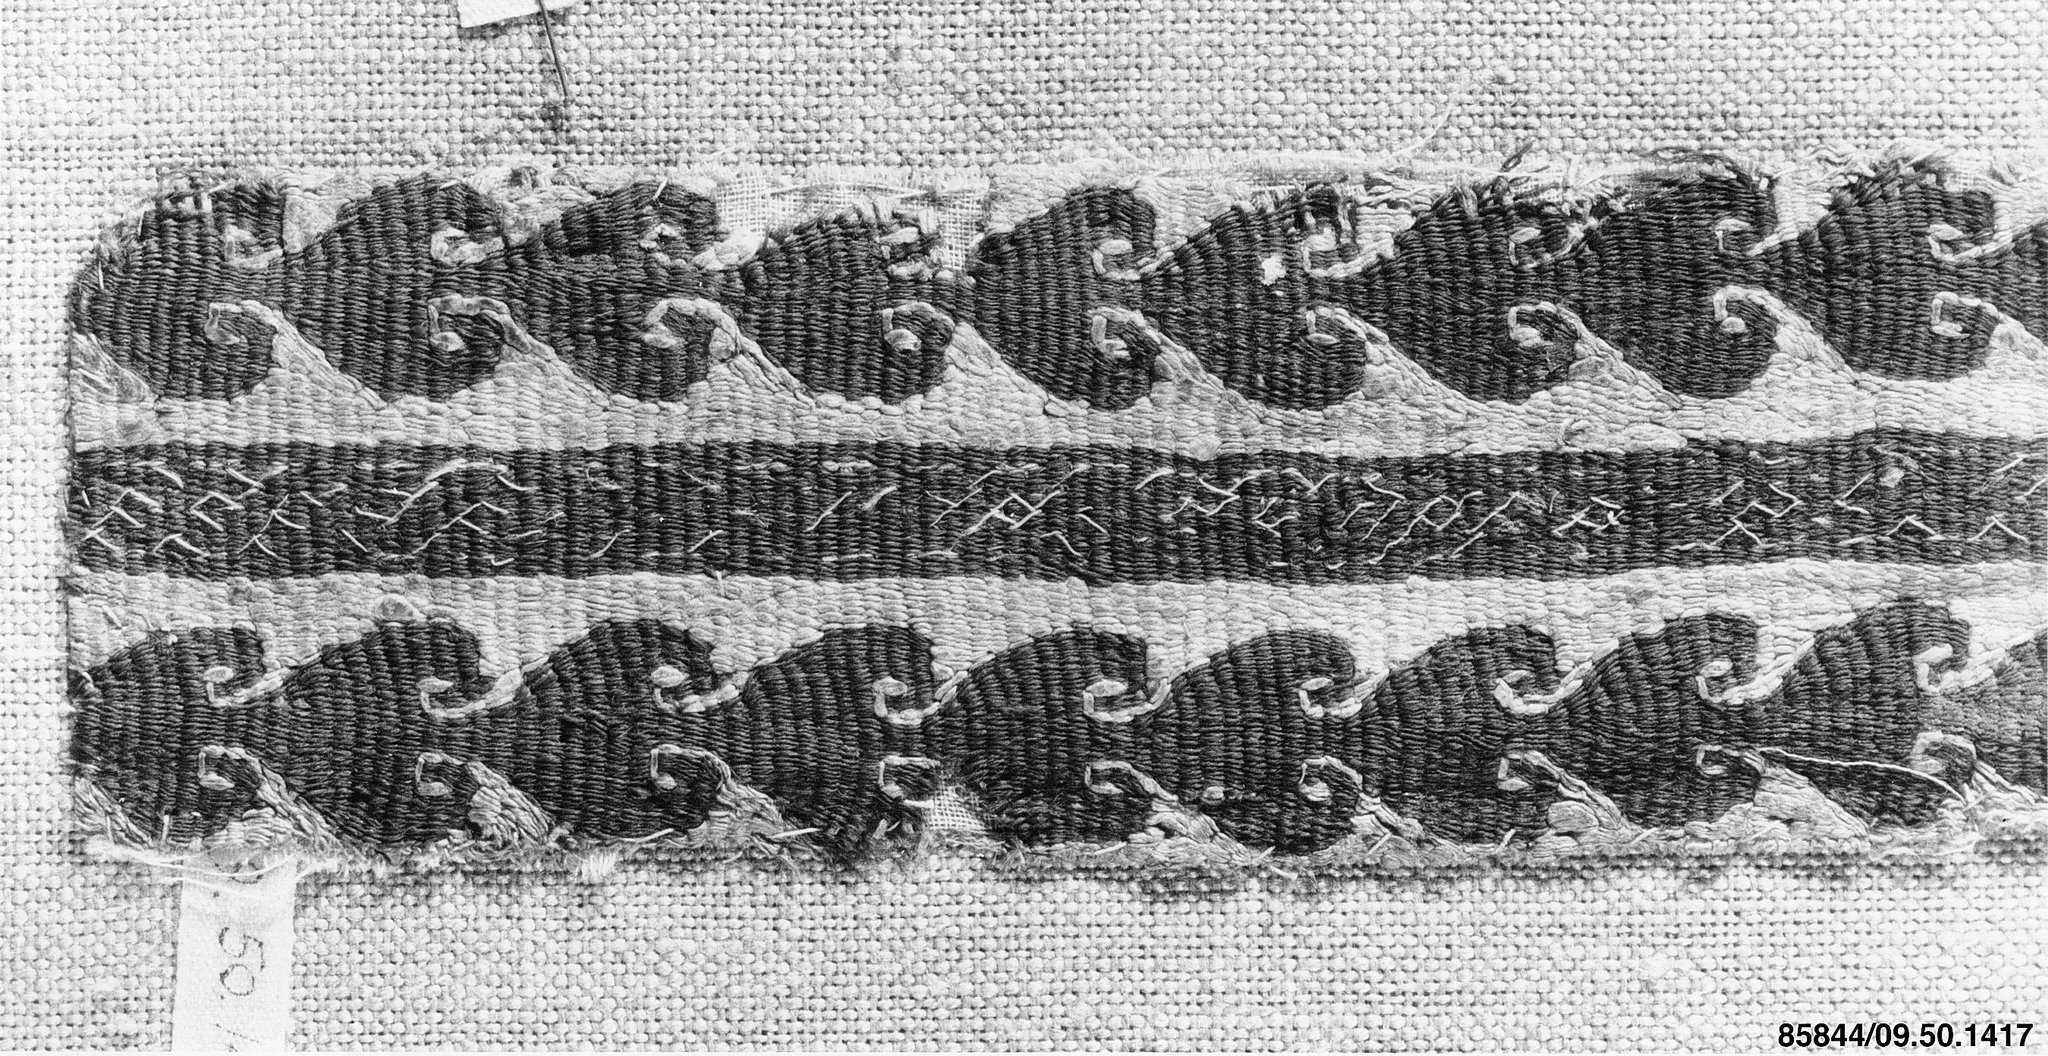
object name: band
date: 201-400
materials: linen, wool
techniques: weave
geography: egypt